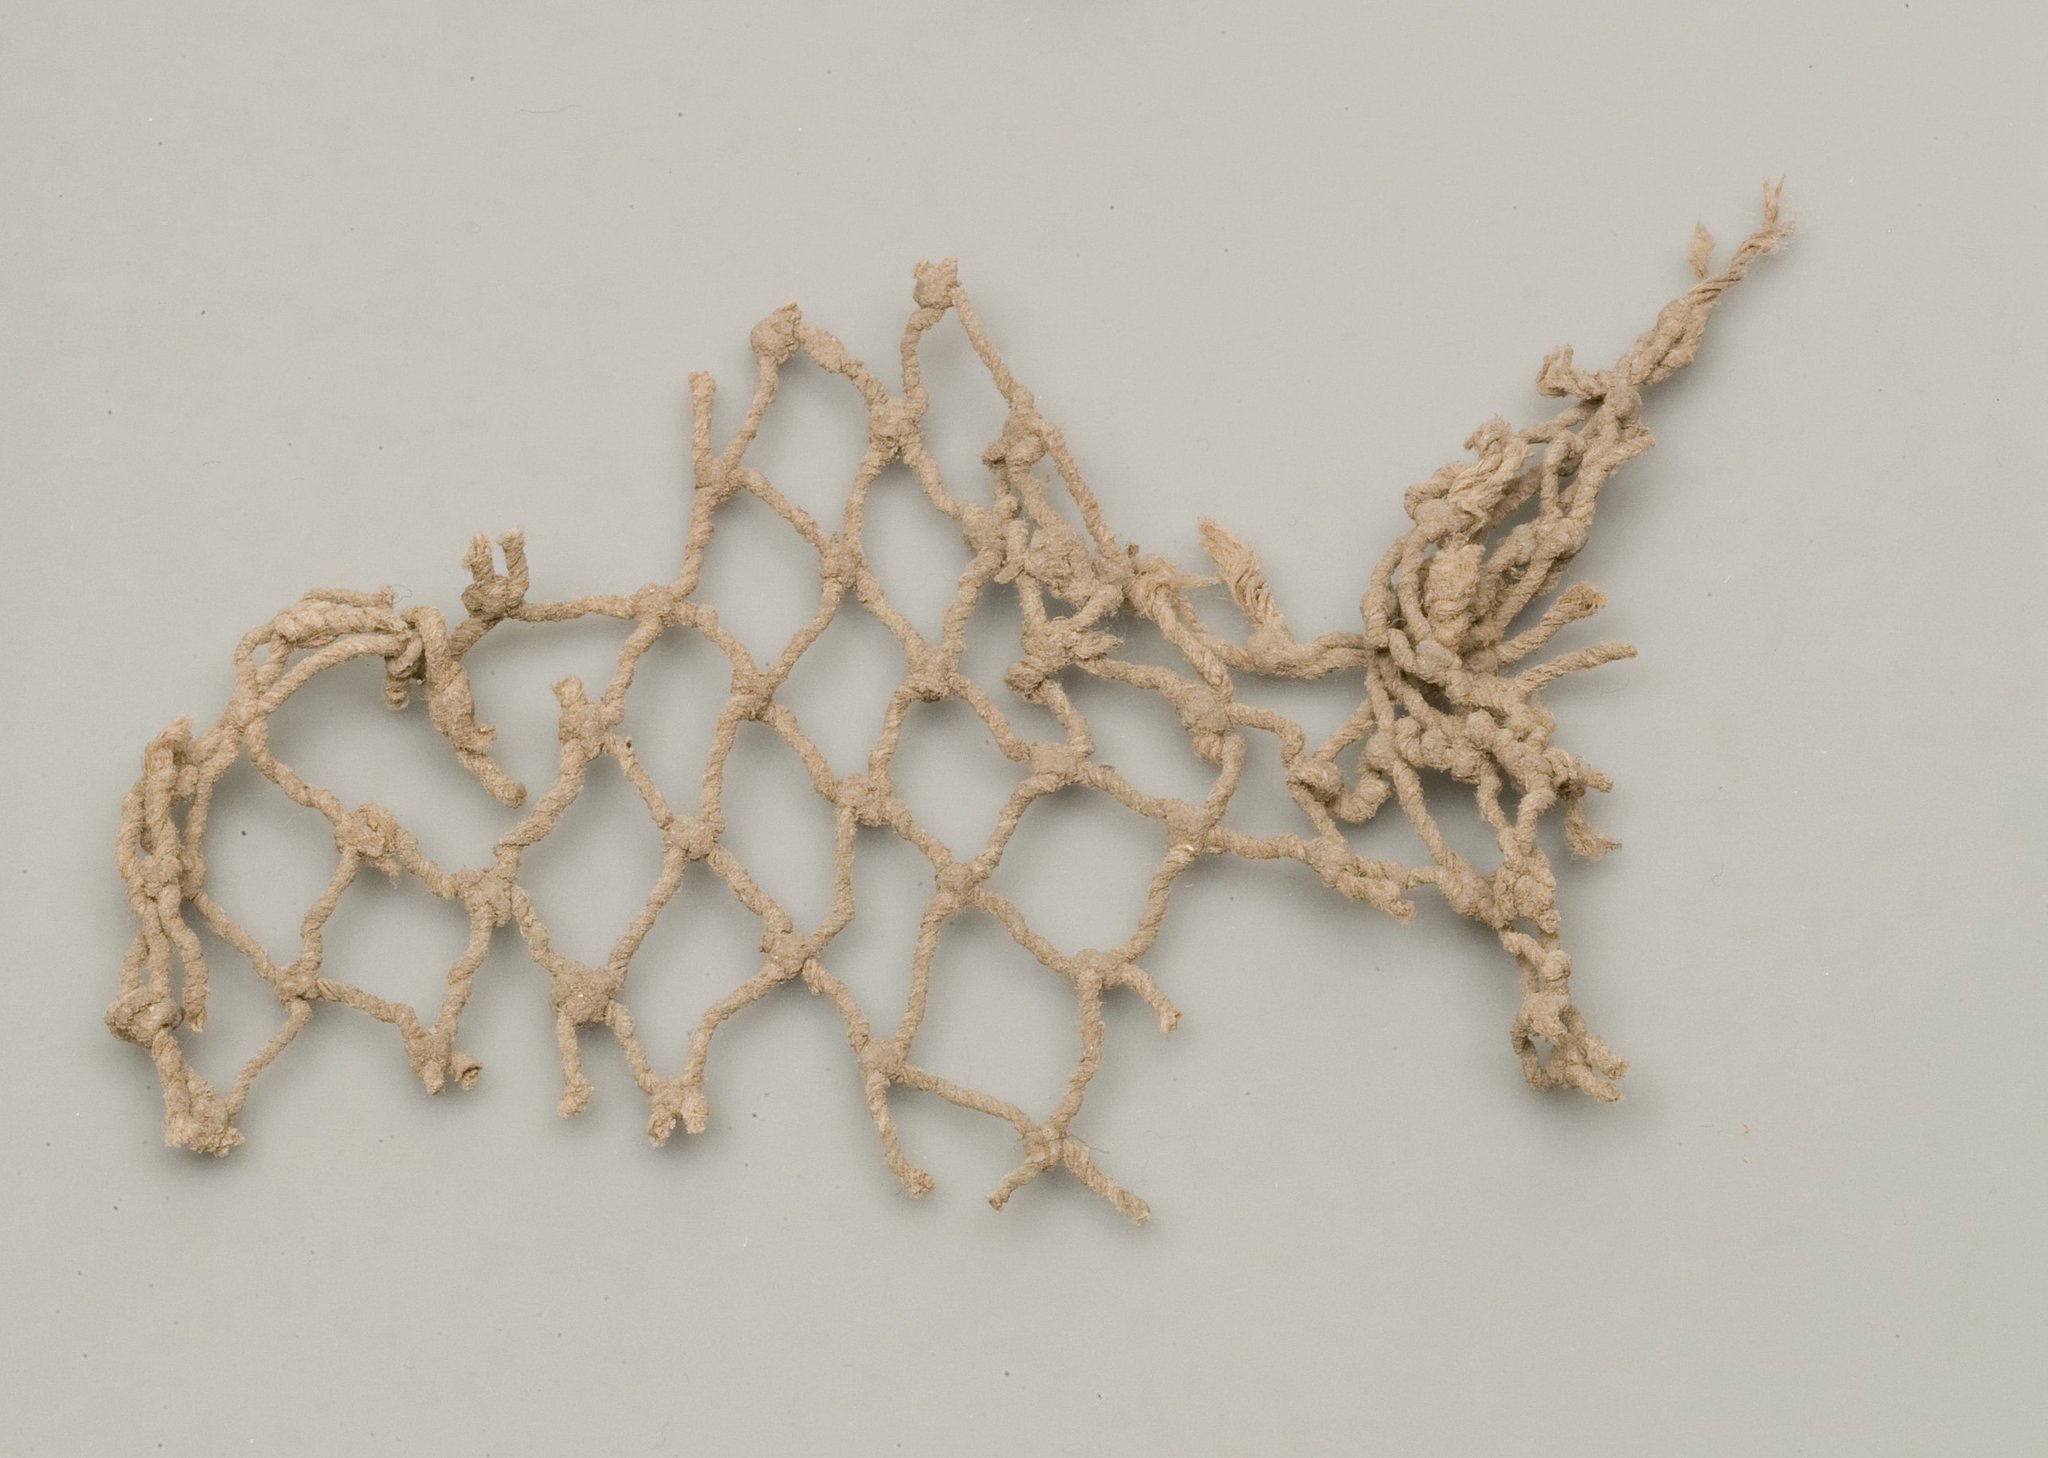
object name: net fragment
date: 1295-1070 BCE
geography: egypt